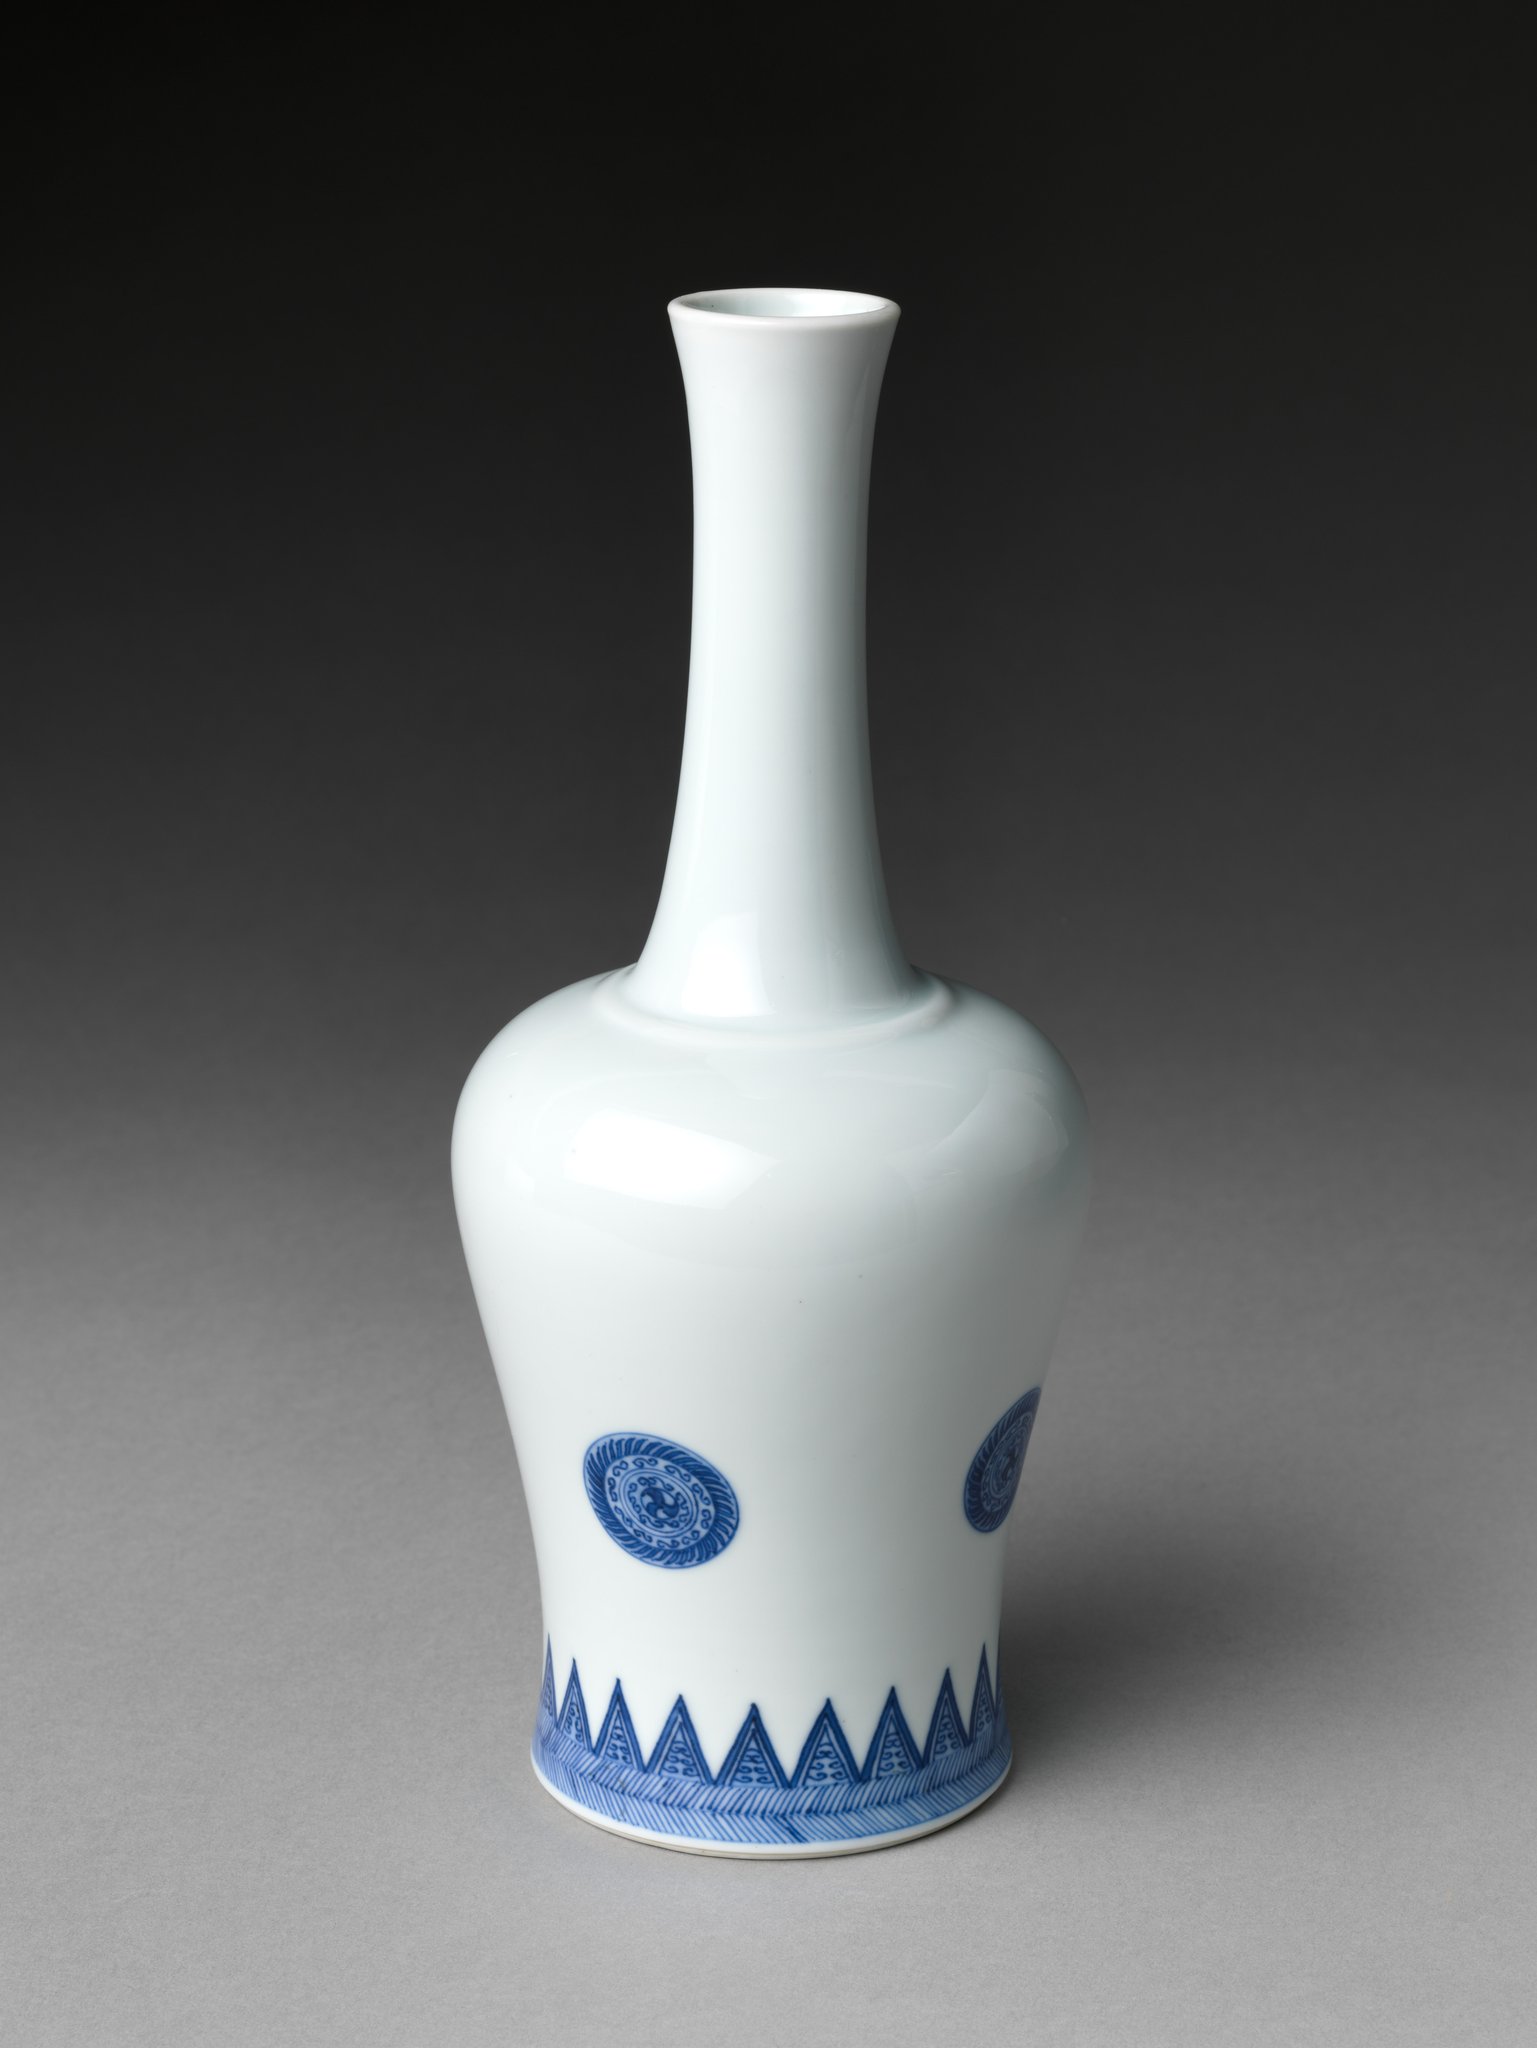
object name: bottle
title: Bottle with Stylized Rosette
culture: chinese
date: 1713-1722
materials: cobalt, porcelain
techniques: painting